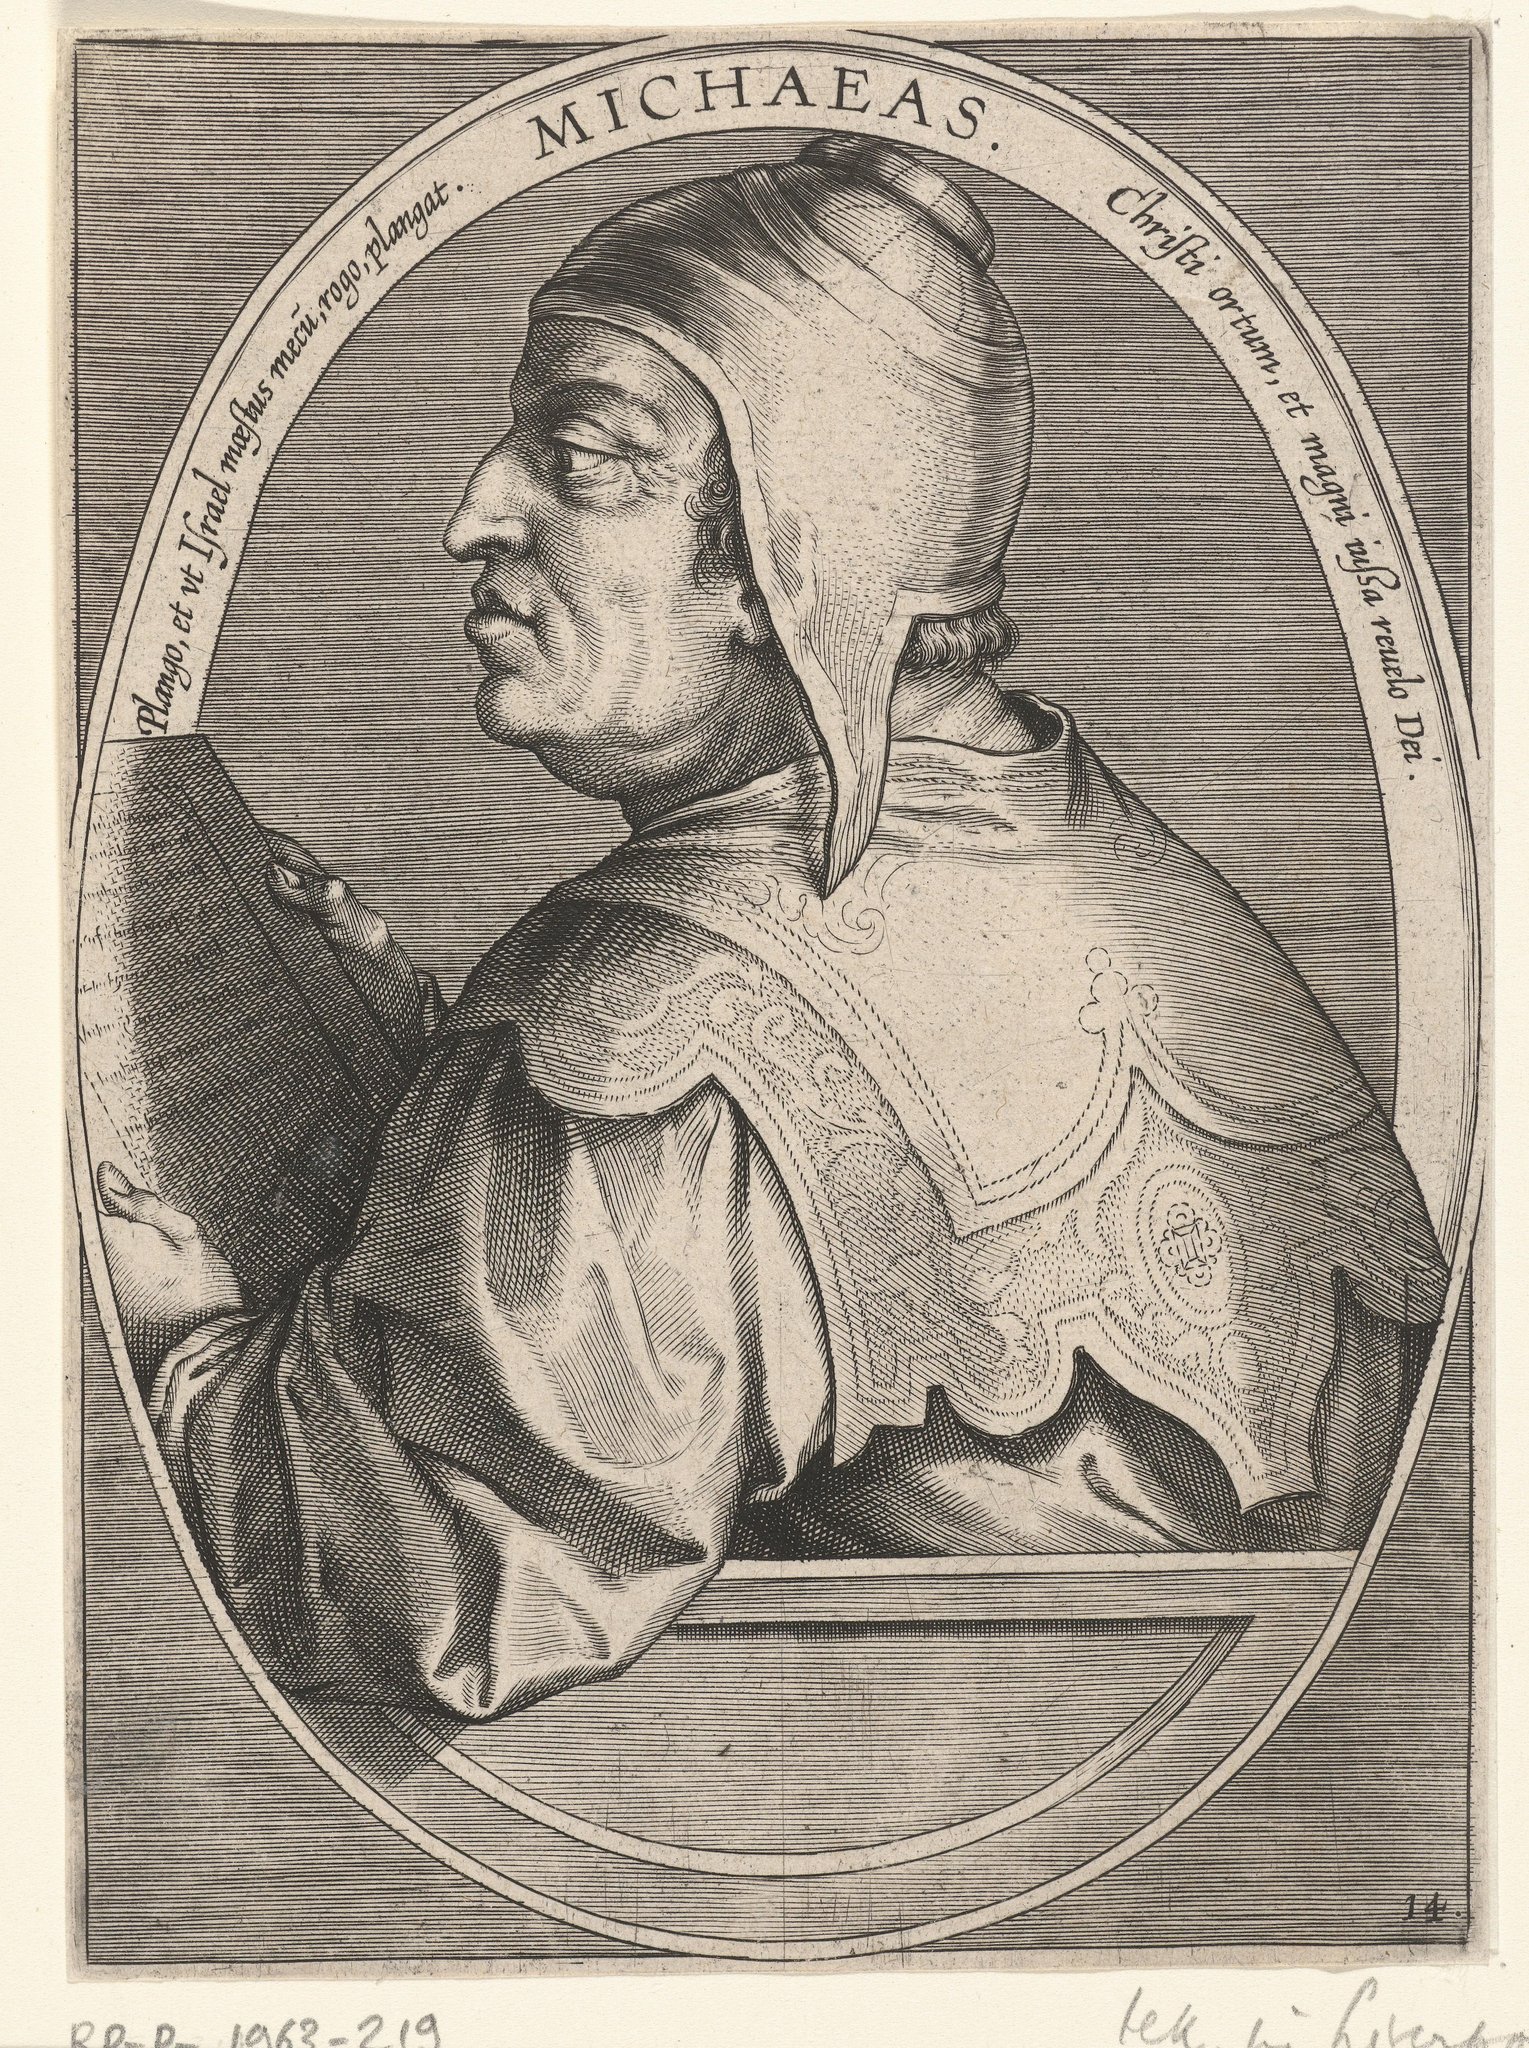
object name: print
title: Micha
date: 1613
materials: paper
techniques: engraving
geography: antwerp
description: De profeet Micha, lezend, met een stuk papier in de hand, in ovaal met randschrift.